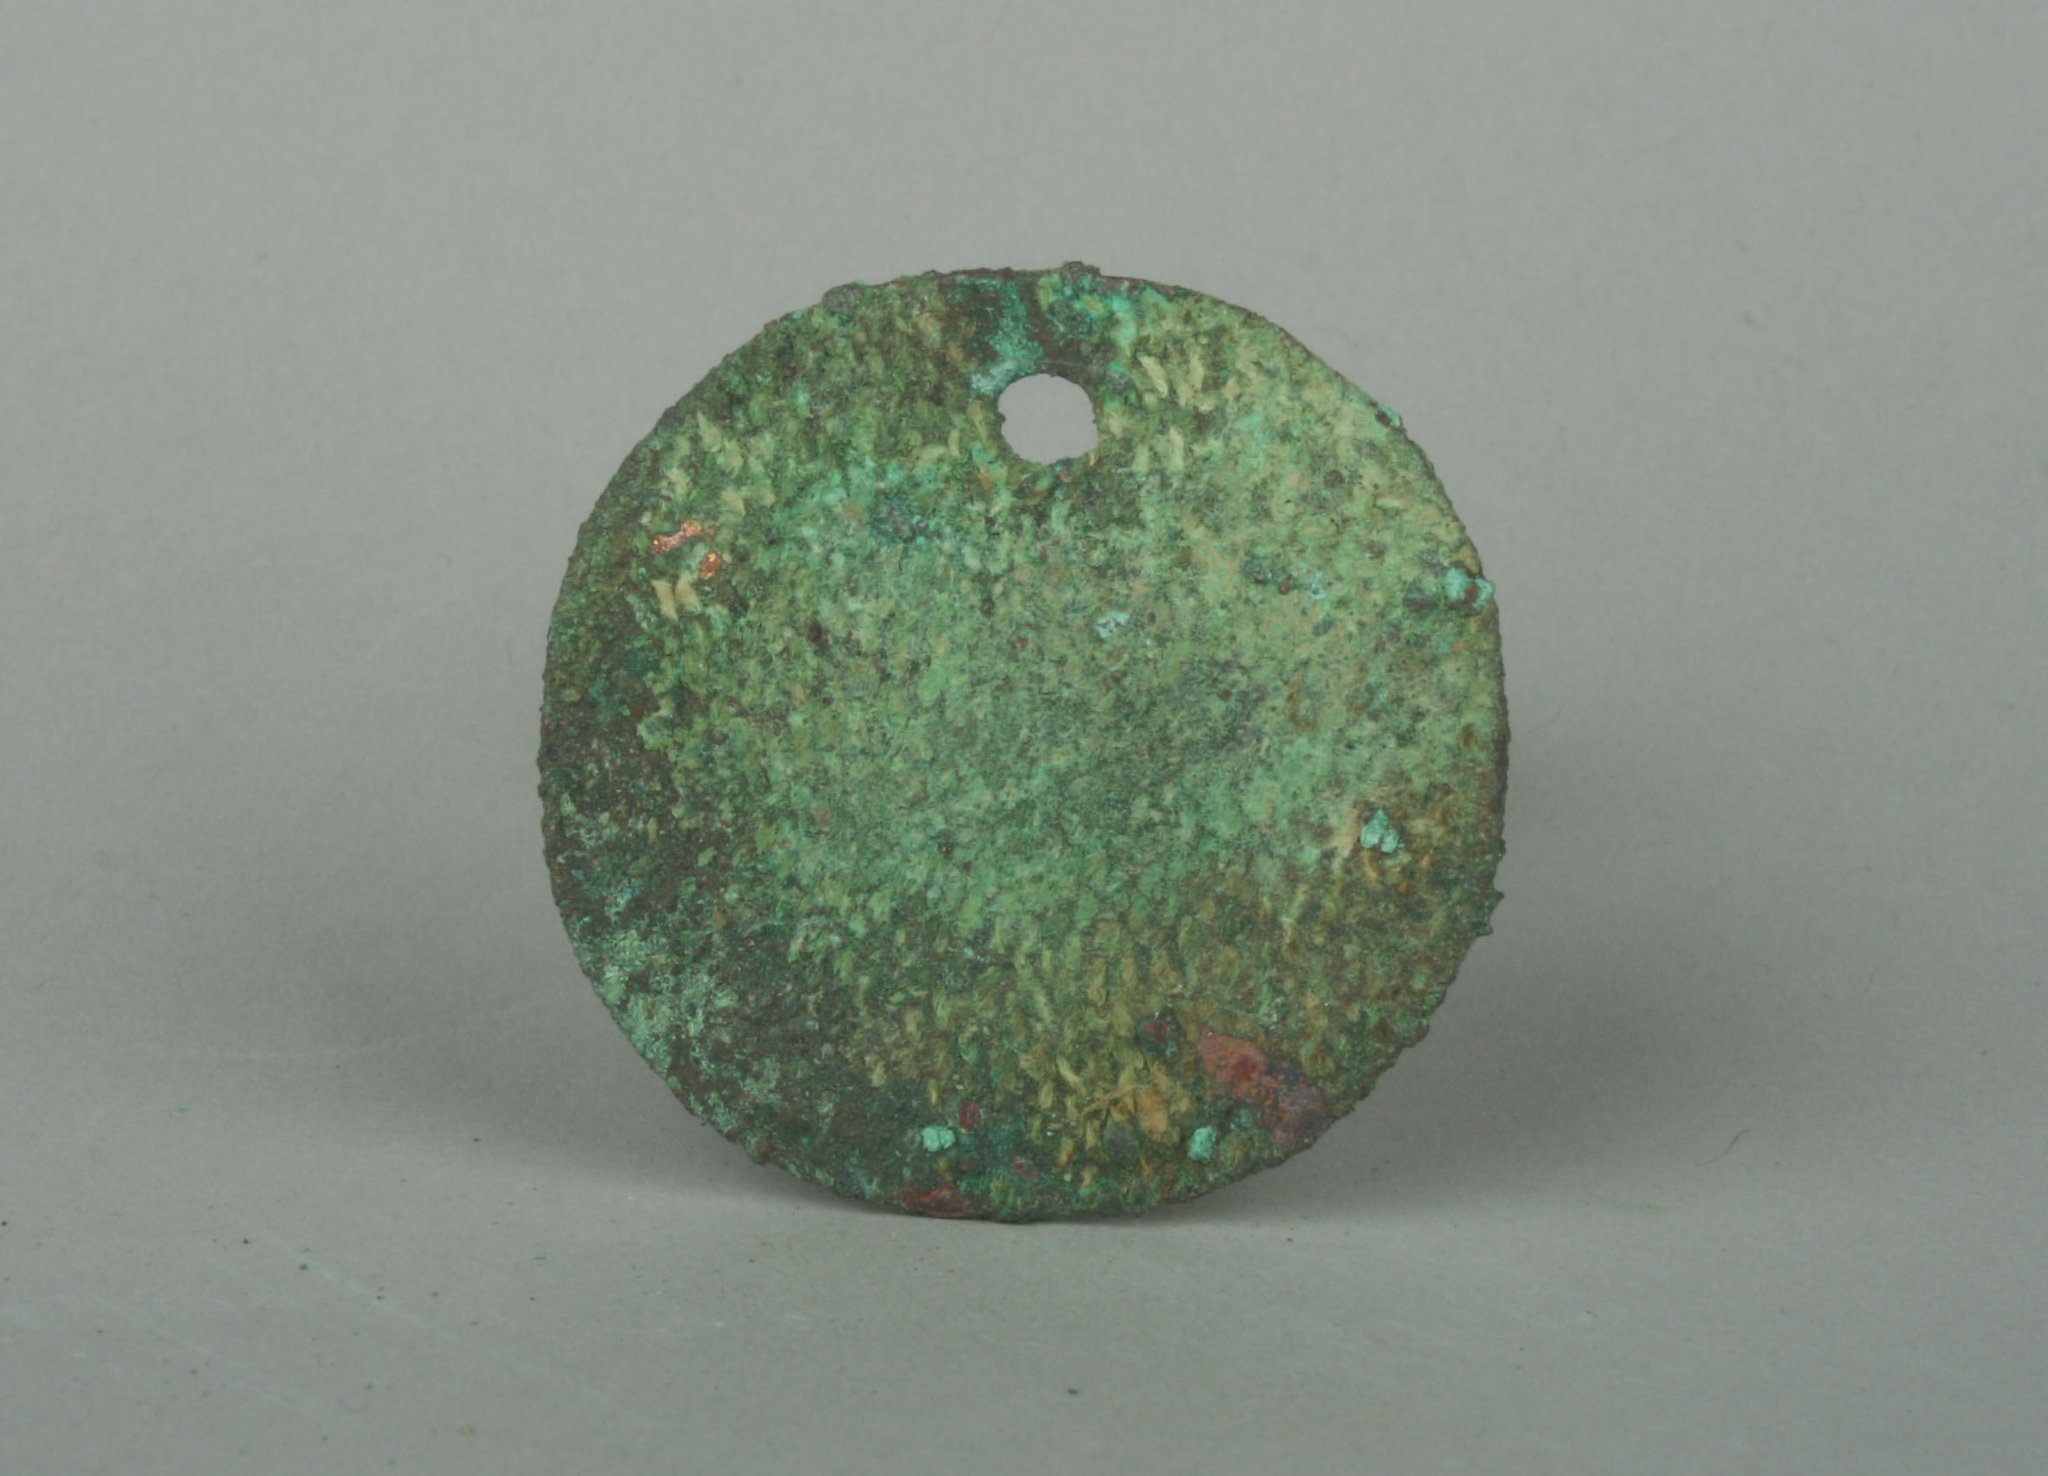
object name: plaque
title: Round Plaque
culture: vicús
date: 300 BCE-200 CE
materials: copper, gilt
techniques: hammering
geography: peru